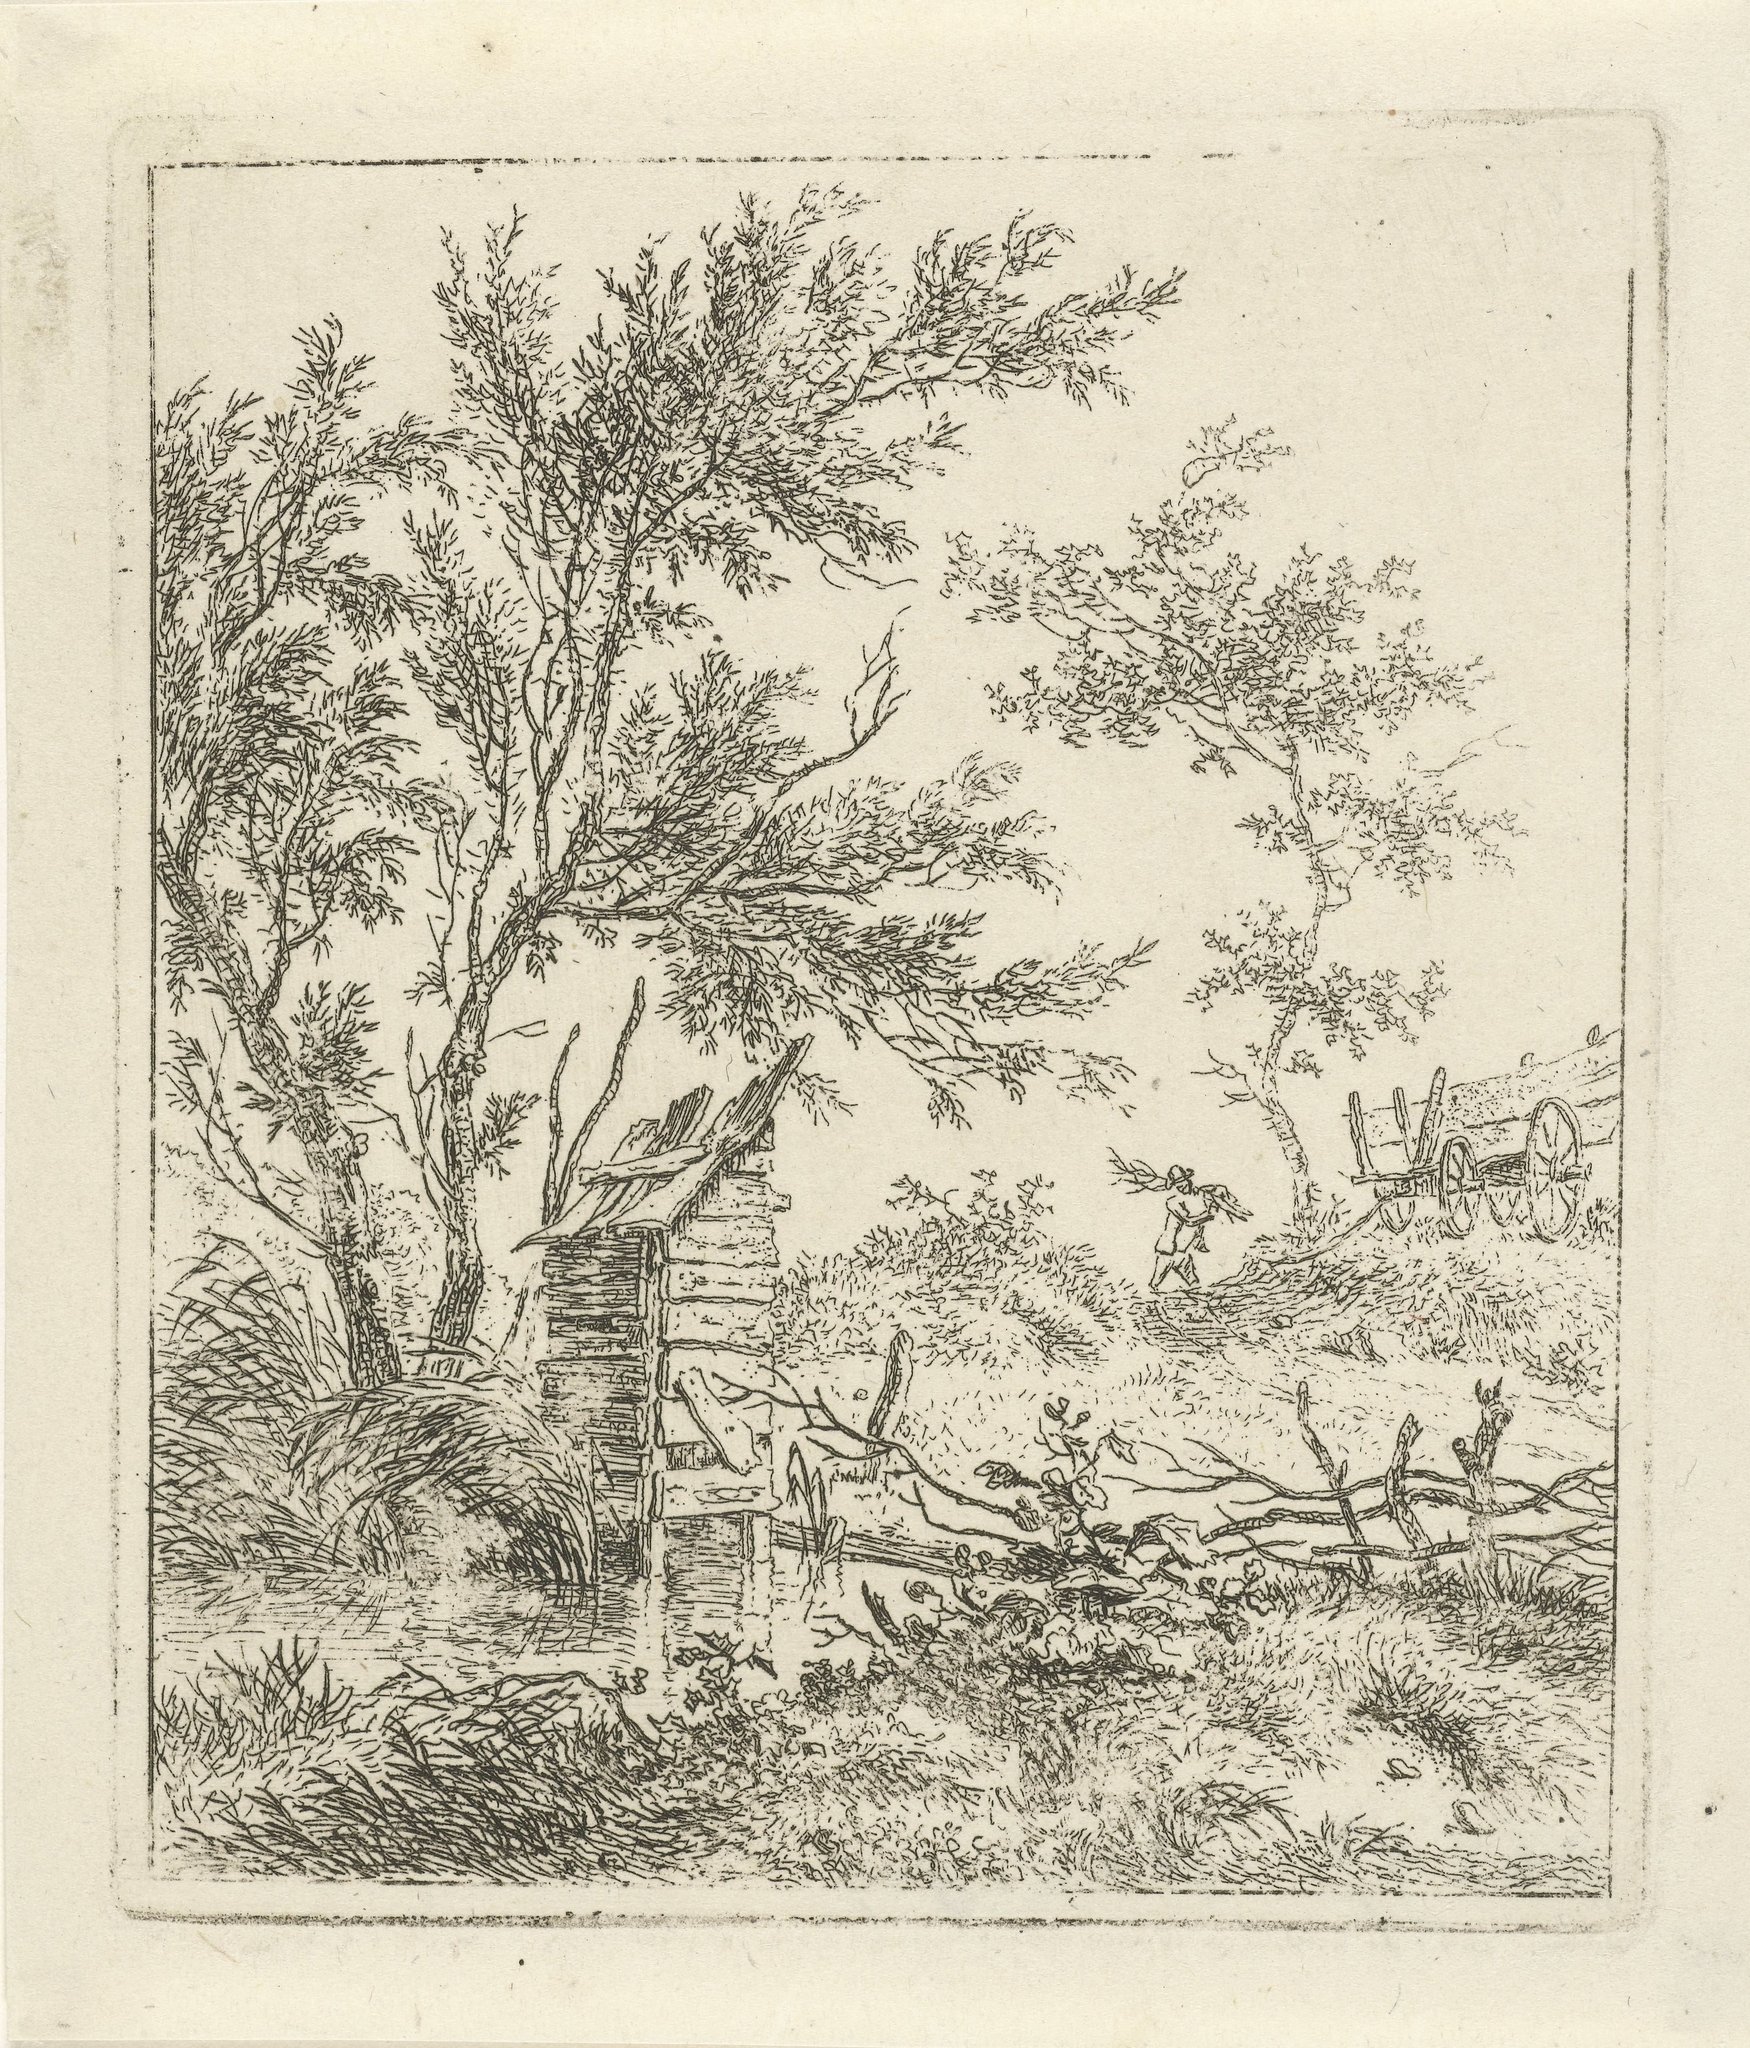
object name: print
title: Landschap met houtsprokkelaar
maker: hermanus fock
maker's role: conservator, draughtsman, painter, print maker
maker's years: 1766-1822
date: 1781-1822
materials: paper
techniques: etching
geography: amsterdam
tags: woodgathering, woodgatherer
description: Een landschap met een houten gebouwtje onder een boom, aan het water. Op de achtergrond brengt een man sprokkelhout naar een kar.